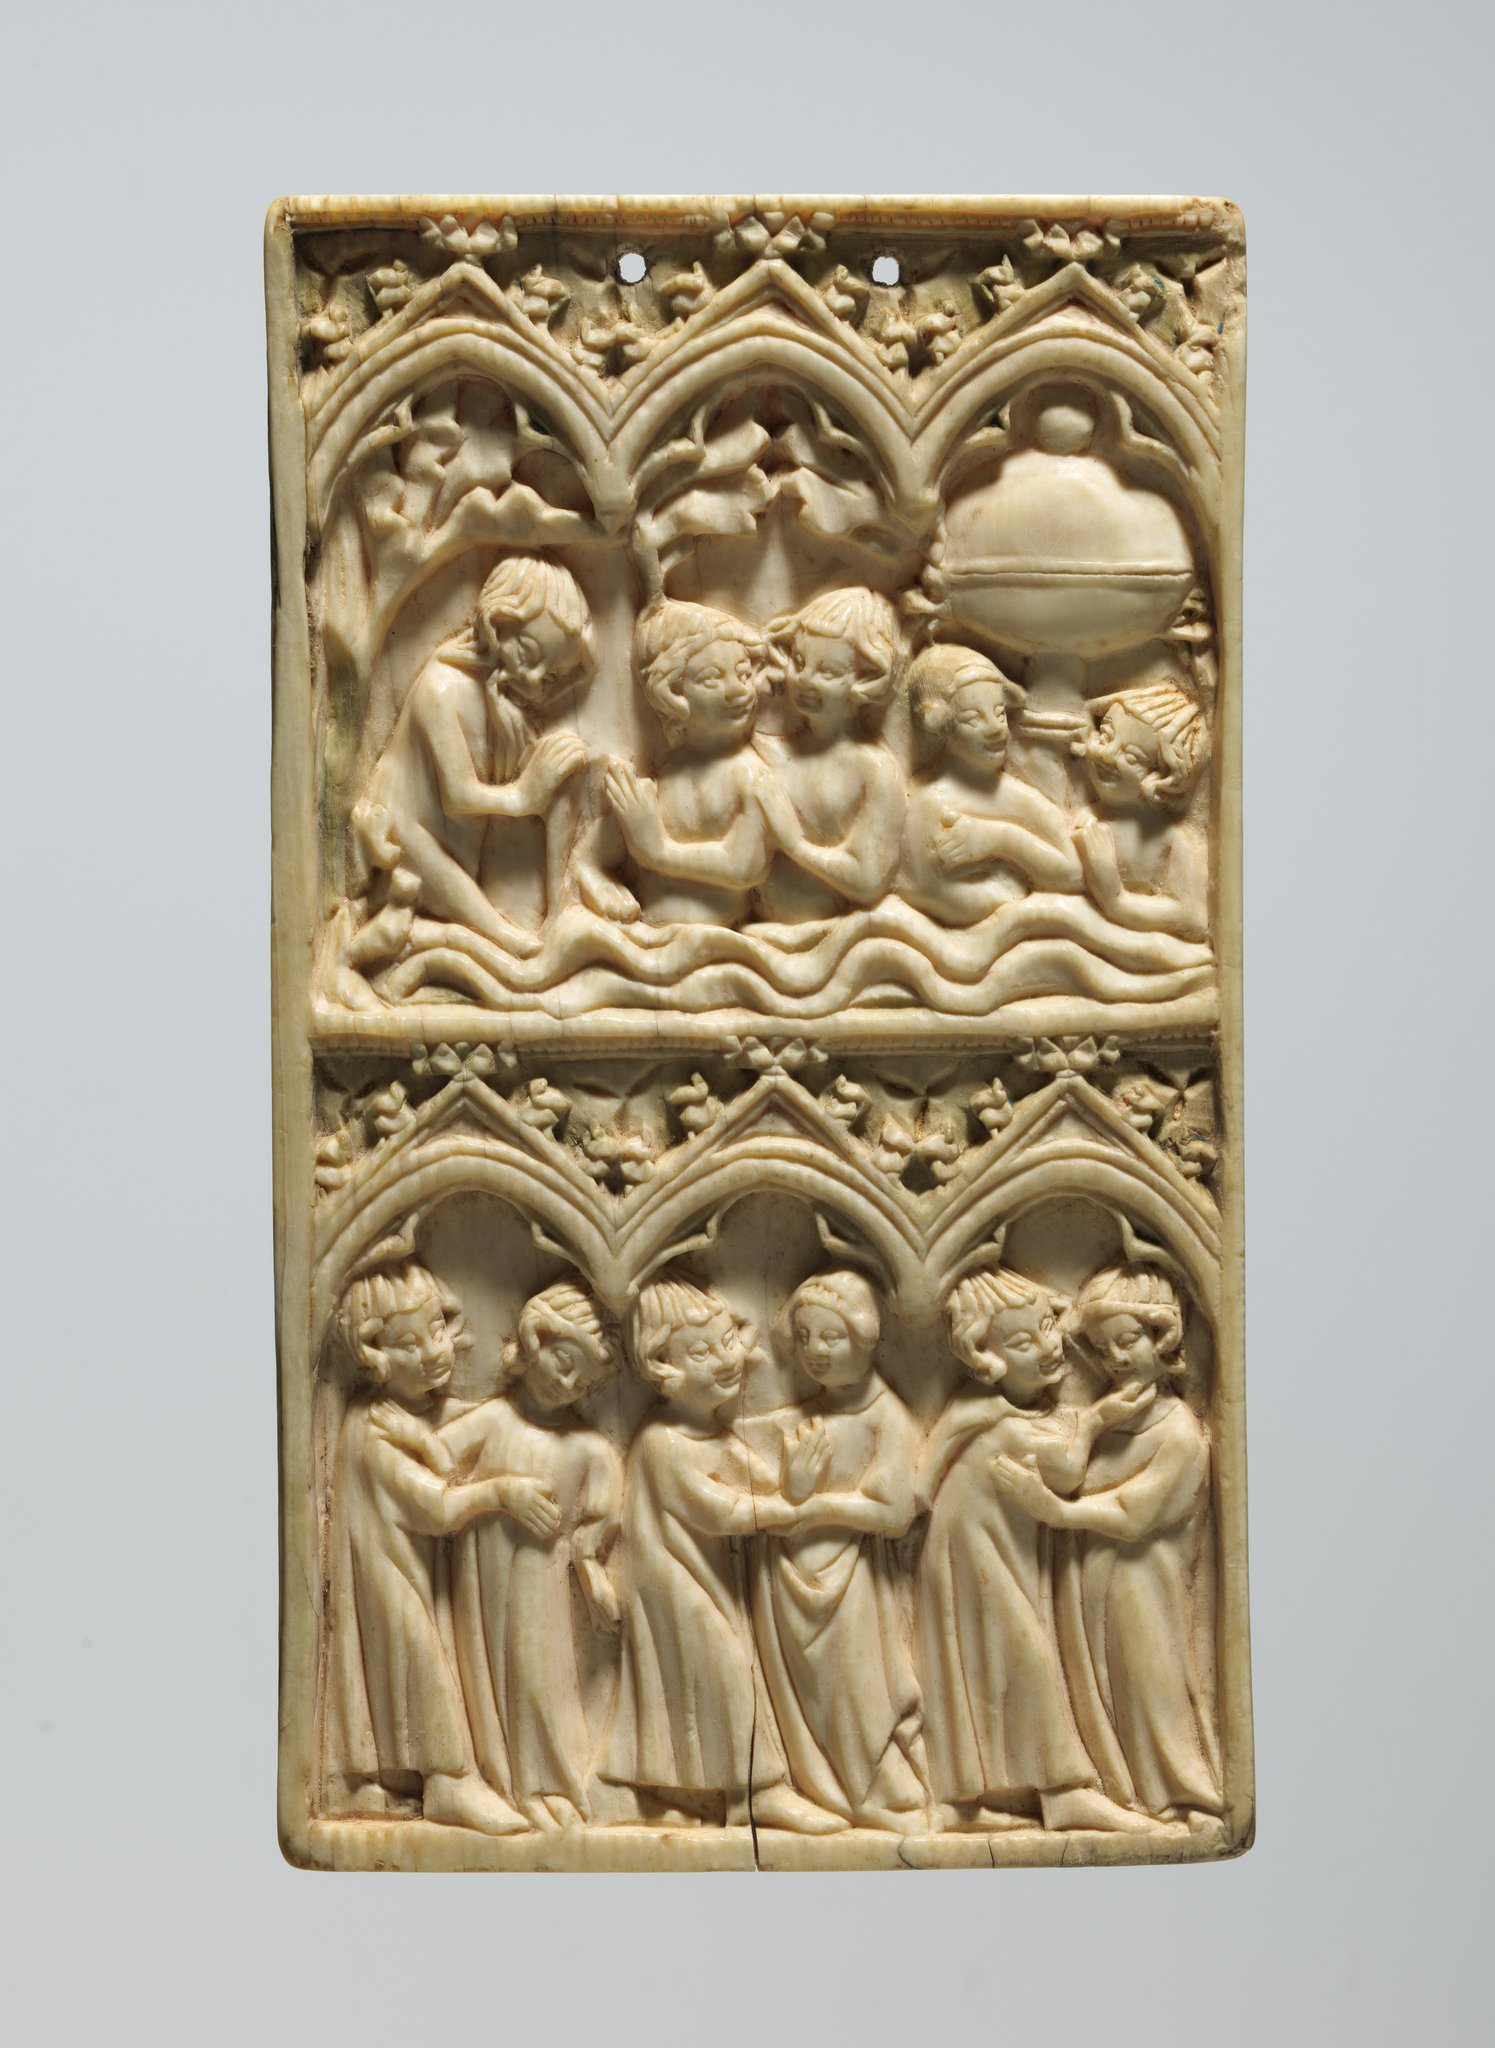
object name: plaque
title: Plaque with the Fountain of Youth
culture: french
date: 1320-1340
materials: ivory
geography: france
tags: fountains,men,women